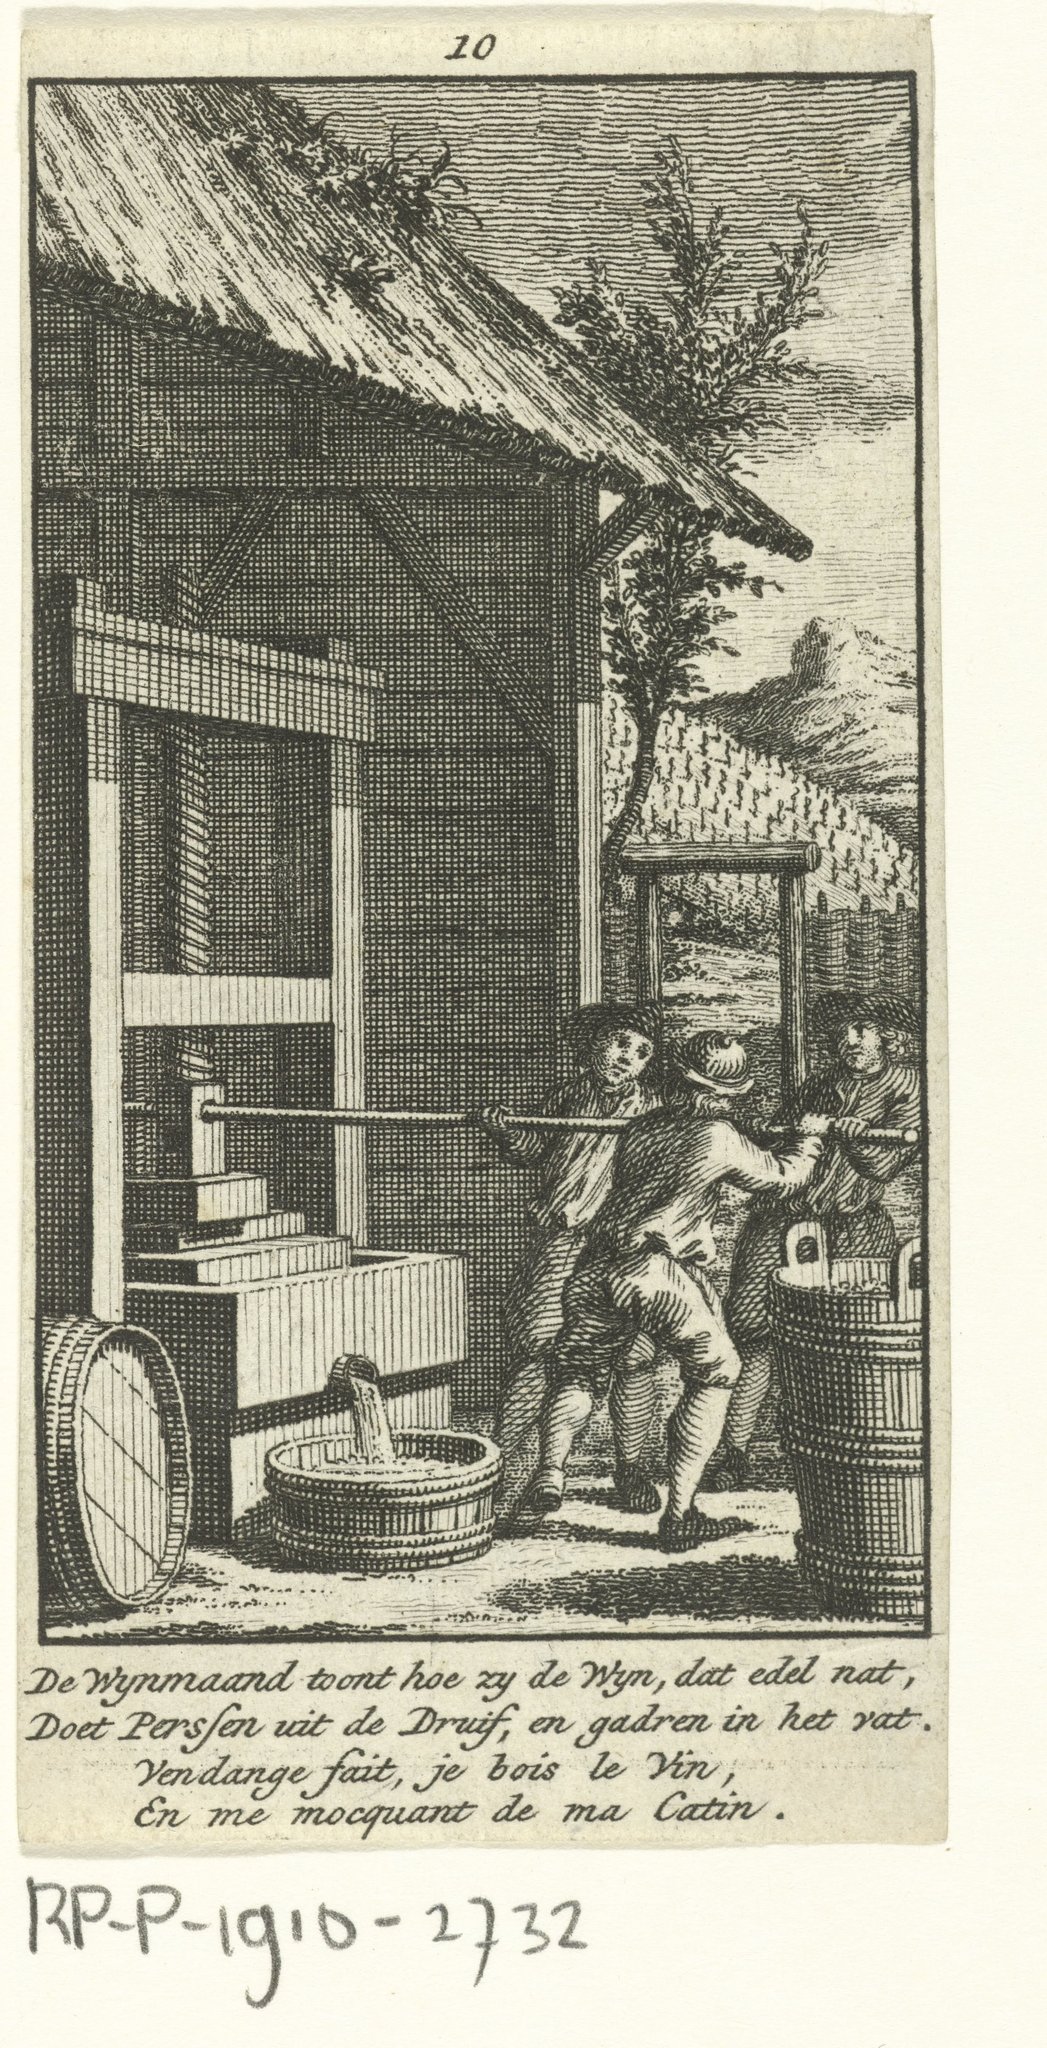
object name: print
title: De twaalf maanden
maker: jan caspar philips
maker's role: draughtsman, print maker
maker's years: 1700-1775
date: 1736-1775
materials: paper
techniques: engraving, etching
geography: amsterdam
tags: october and its 'labours'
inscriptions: collector's mark: Lugt 2228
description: De maand oktober: drie mannen bedienen een druivenpers. Op de achtergrond op een heuvel een wijngaard. In de marge een tweeregelig gedicht in het Nederlands en in het Frans.